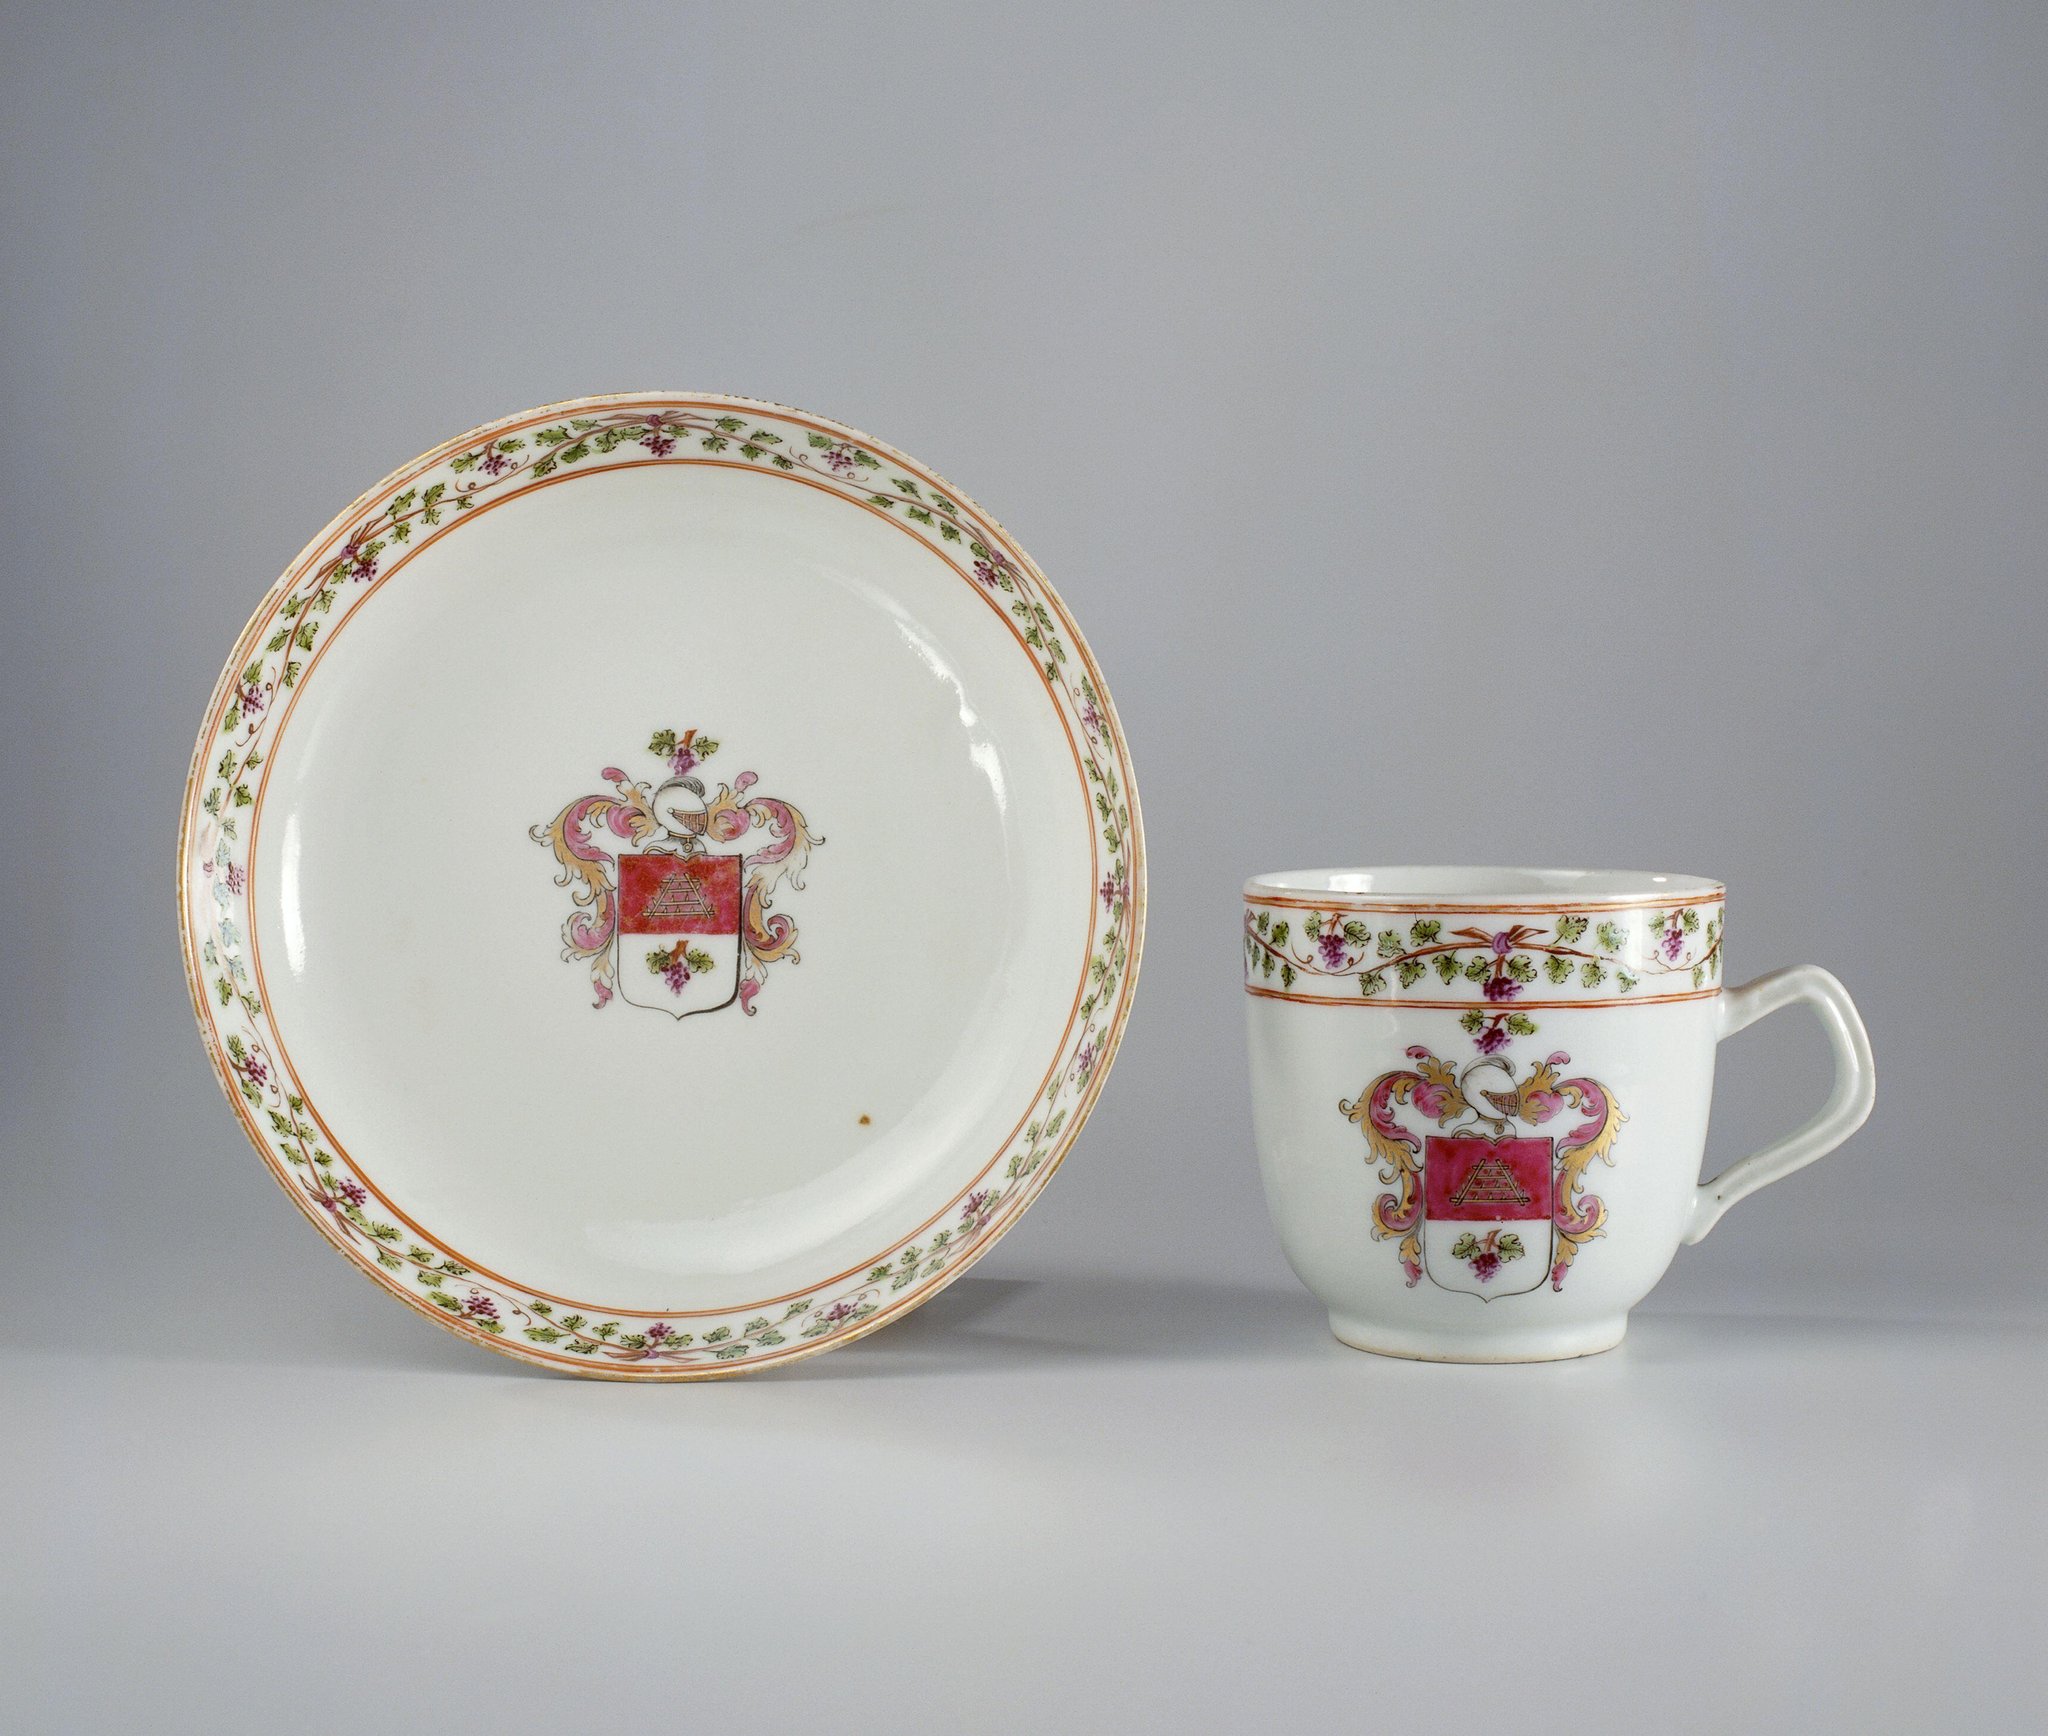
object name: cup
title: Cup with handle with a coat of arms and a monogram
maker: Anonymous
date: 1750-1774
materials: glaze, gold, paint, porcelain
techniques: firing, gilding, turning, vitrification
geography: china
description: Oorkop van porselein, beschilderd op het glazuur in rood, roze, groen, bruin, paars, zwart en goud. Op de wand een ongeïdentificeerd familiewapen verdeeld in twee vakken met in 1. een object op een roze grond; 2. een druiventak tegen een witte achtergrond. Het helmteken is een druiventak. Het wapen is omgeven door bladranken. Op de rand een band met druivenranken. Een tweede wapen met het monogram 'G.R.[?]'. Wapenporselein met emailkleuren.